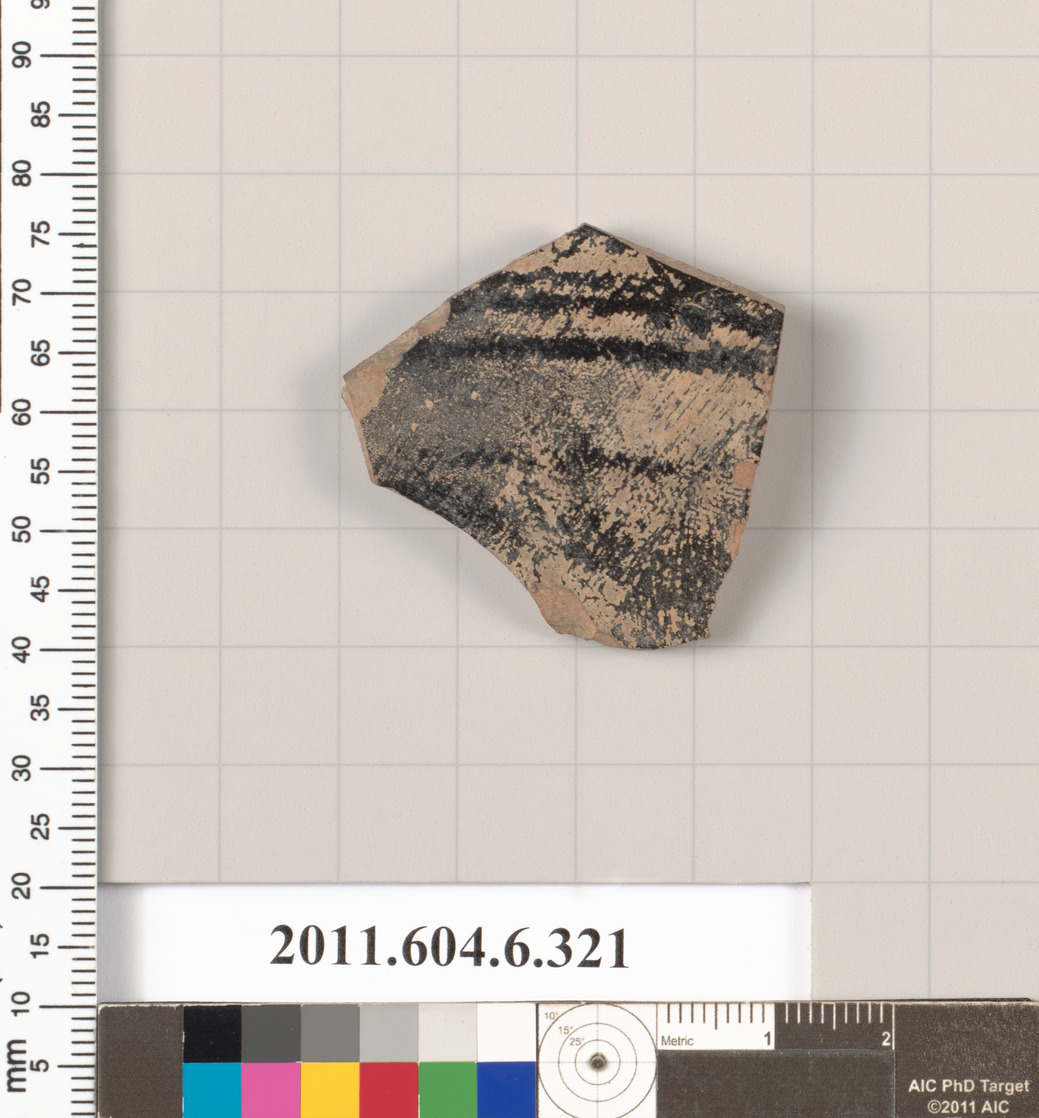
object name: undetermined closed shape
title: Terracotta fragment of a closed shape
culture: greek, attic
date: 600-401 BCE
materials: terracotta